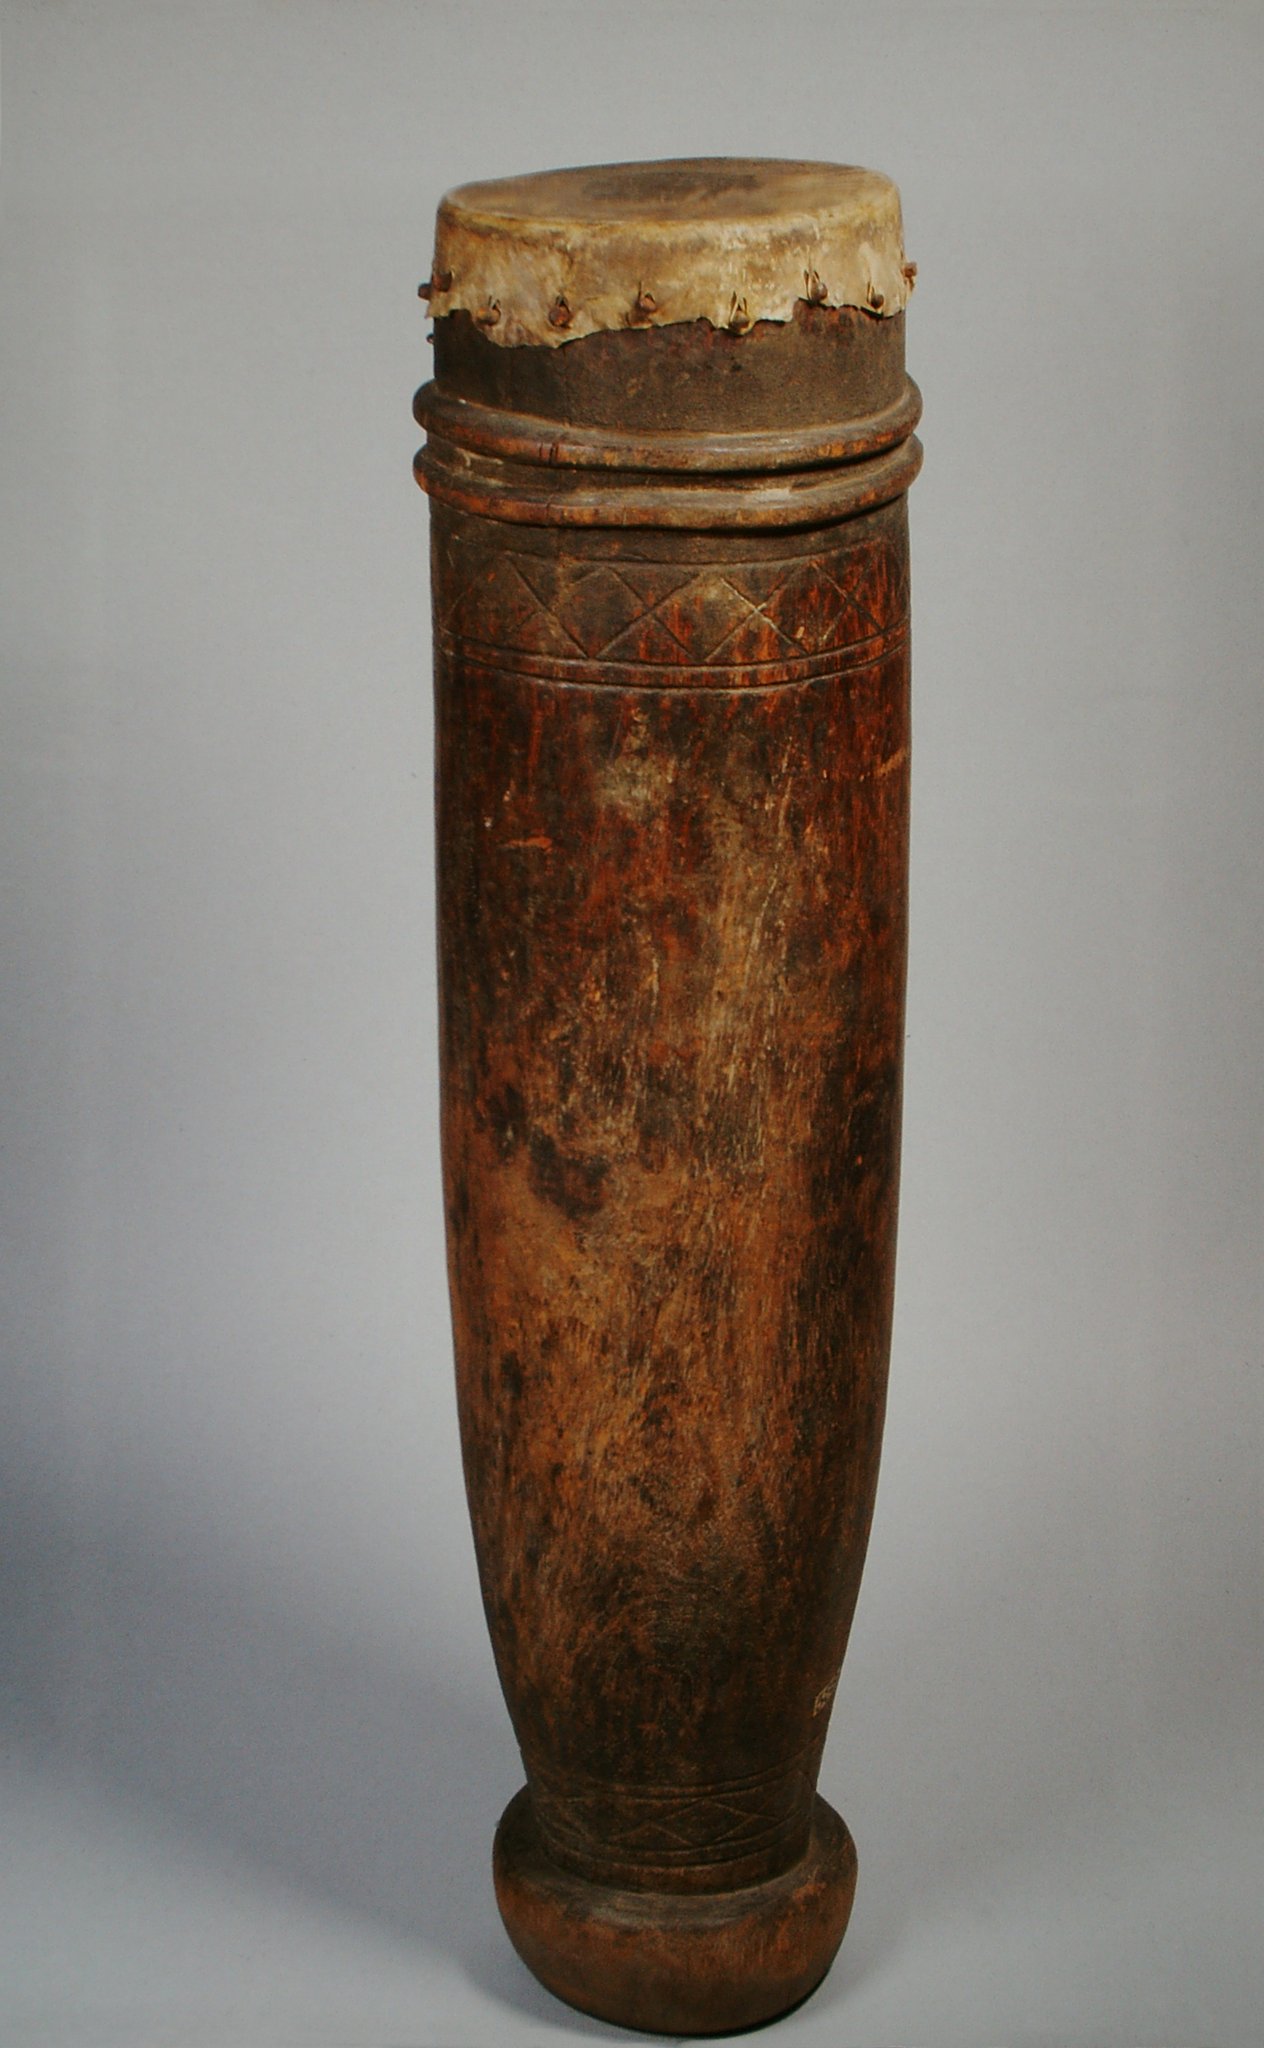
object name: drum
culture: mbala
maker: mbala people?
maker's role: maker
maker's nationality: dem. republic of the congo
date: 1801-1900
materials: wood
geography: democratic republic of the congo